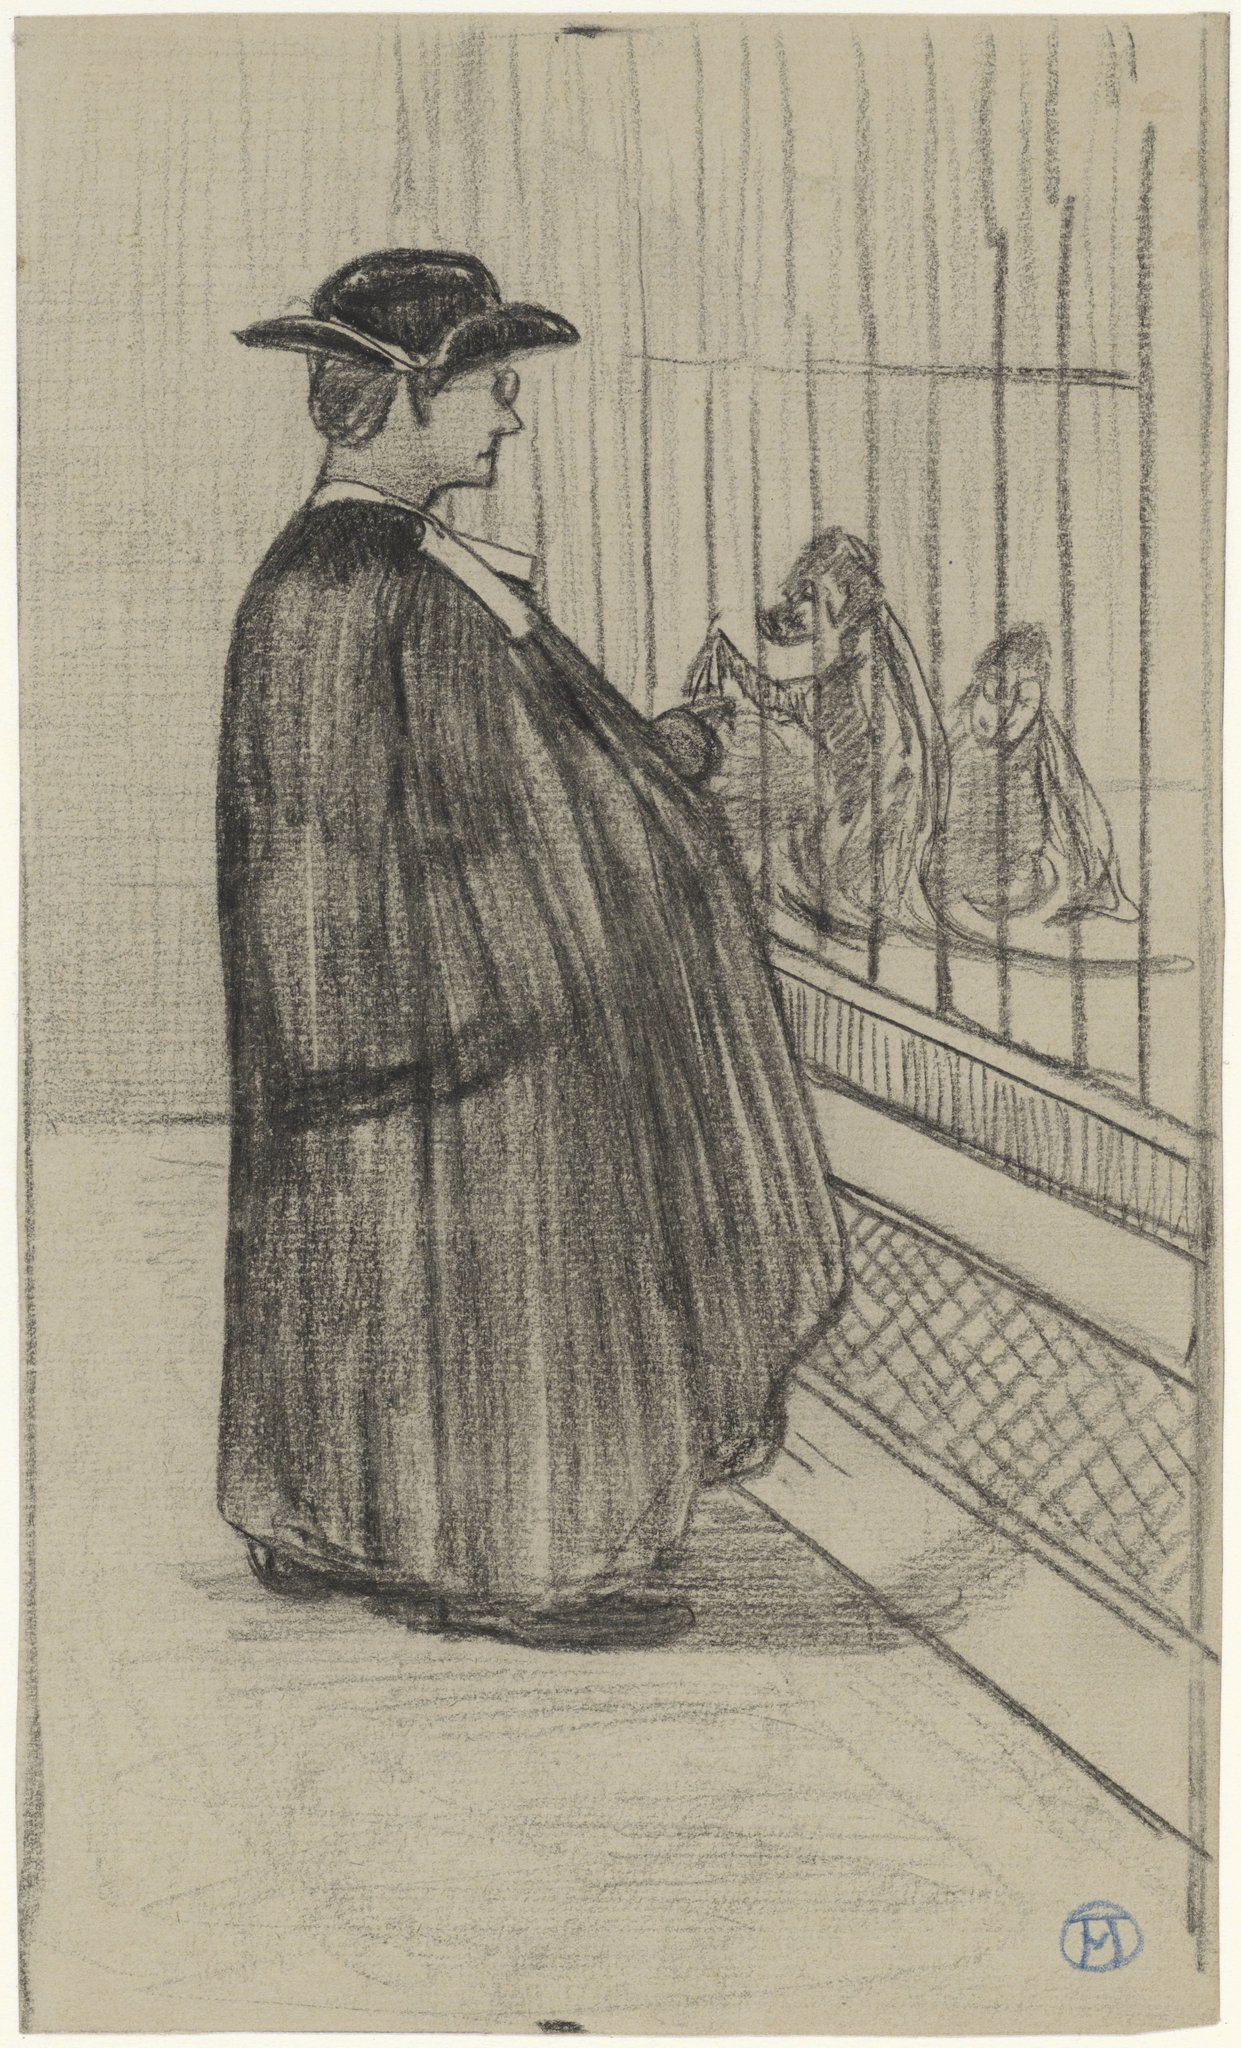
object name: drawing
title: Pastoor bij een apenkooi in een dierentuin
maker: theo van hoytema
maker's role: draughtsman, painter, print maker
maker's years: 1863-1917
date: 1873-1917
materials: chalk, paper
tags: priest (roman catholic), monkeys, apes, zoological garden, zoo, seen as place where non-domestic animals are kept, zoo (as place of recreation)